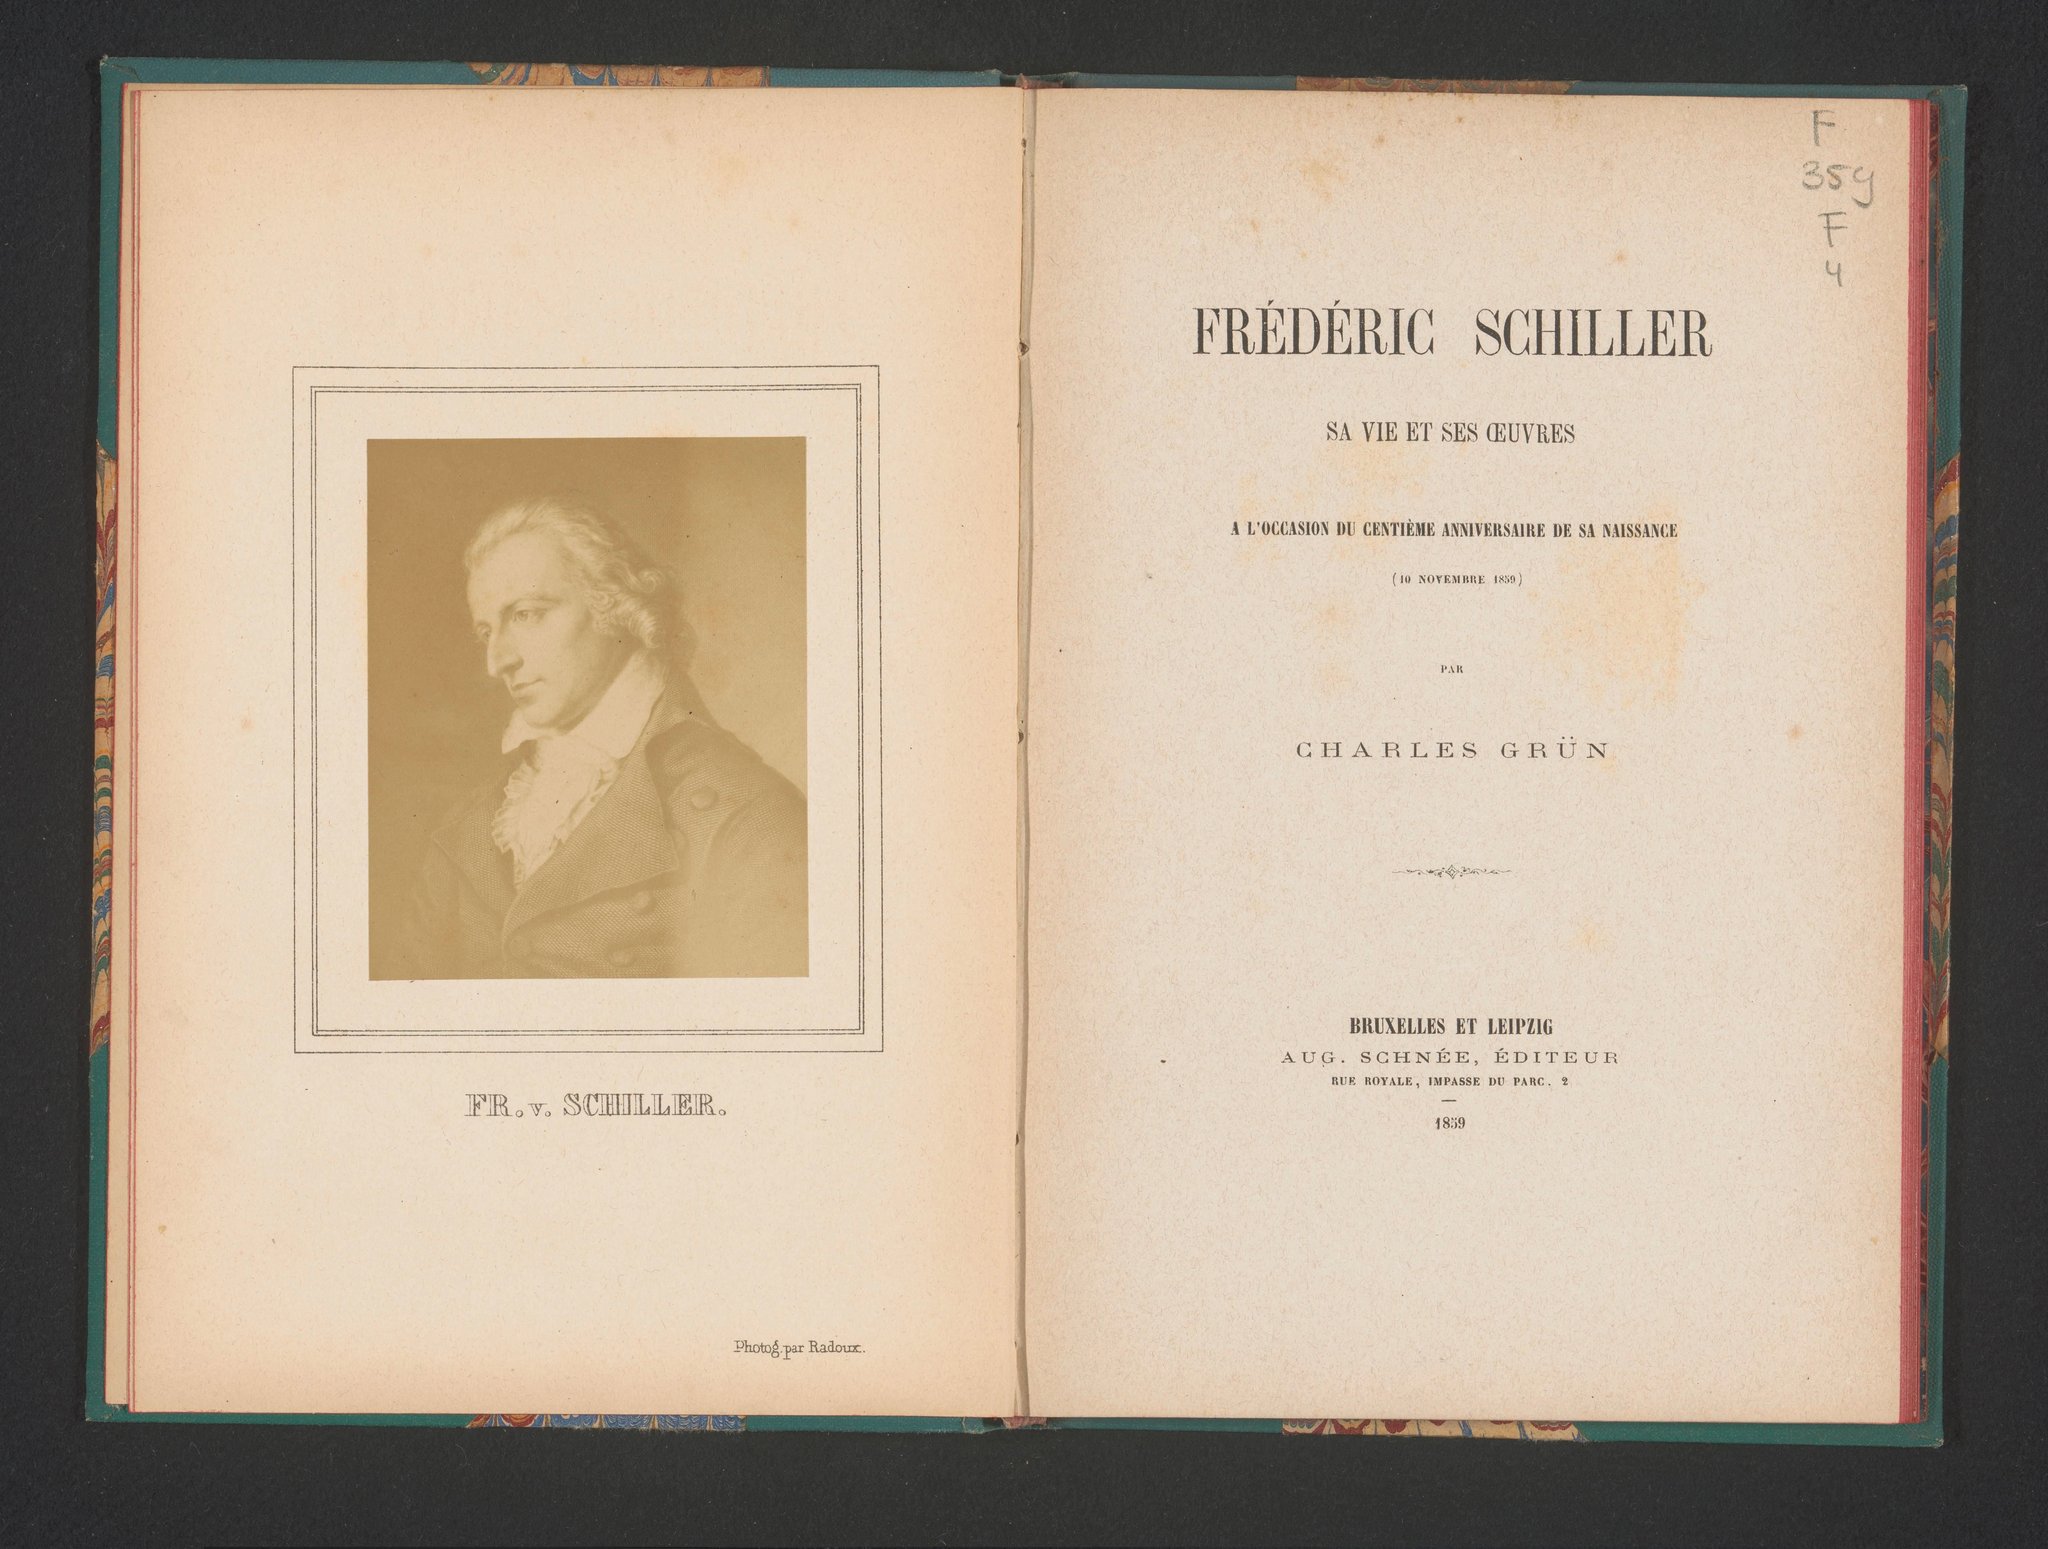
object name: book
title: Frédéric Schiller, sa vie et ses oeuvres : à l'occasion du centième anniversaire de sa naissance (10 novembre 1859) / par Charles Grün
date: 1859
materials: cardboard, linen, paper, photographic support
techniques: albumen print, printing, marbled paper, marbling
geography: leipzig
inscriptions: annotation: ‘Photo mis de Radaux’